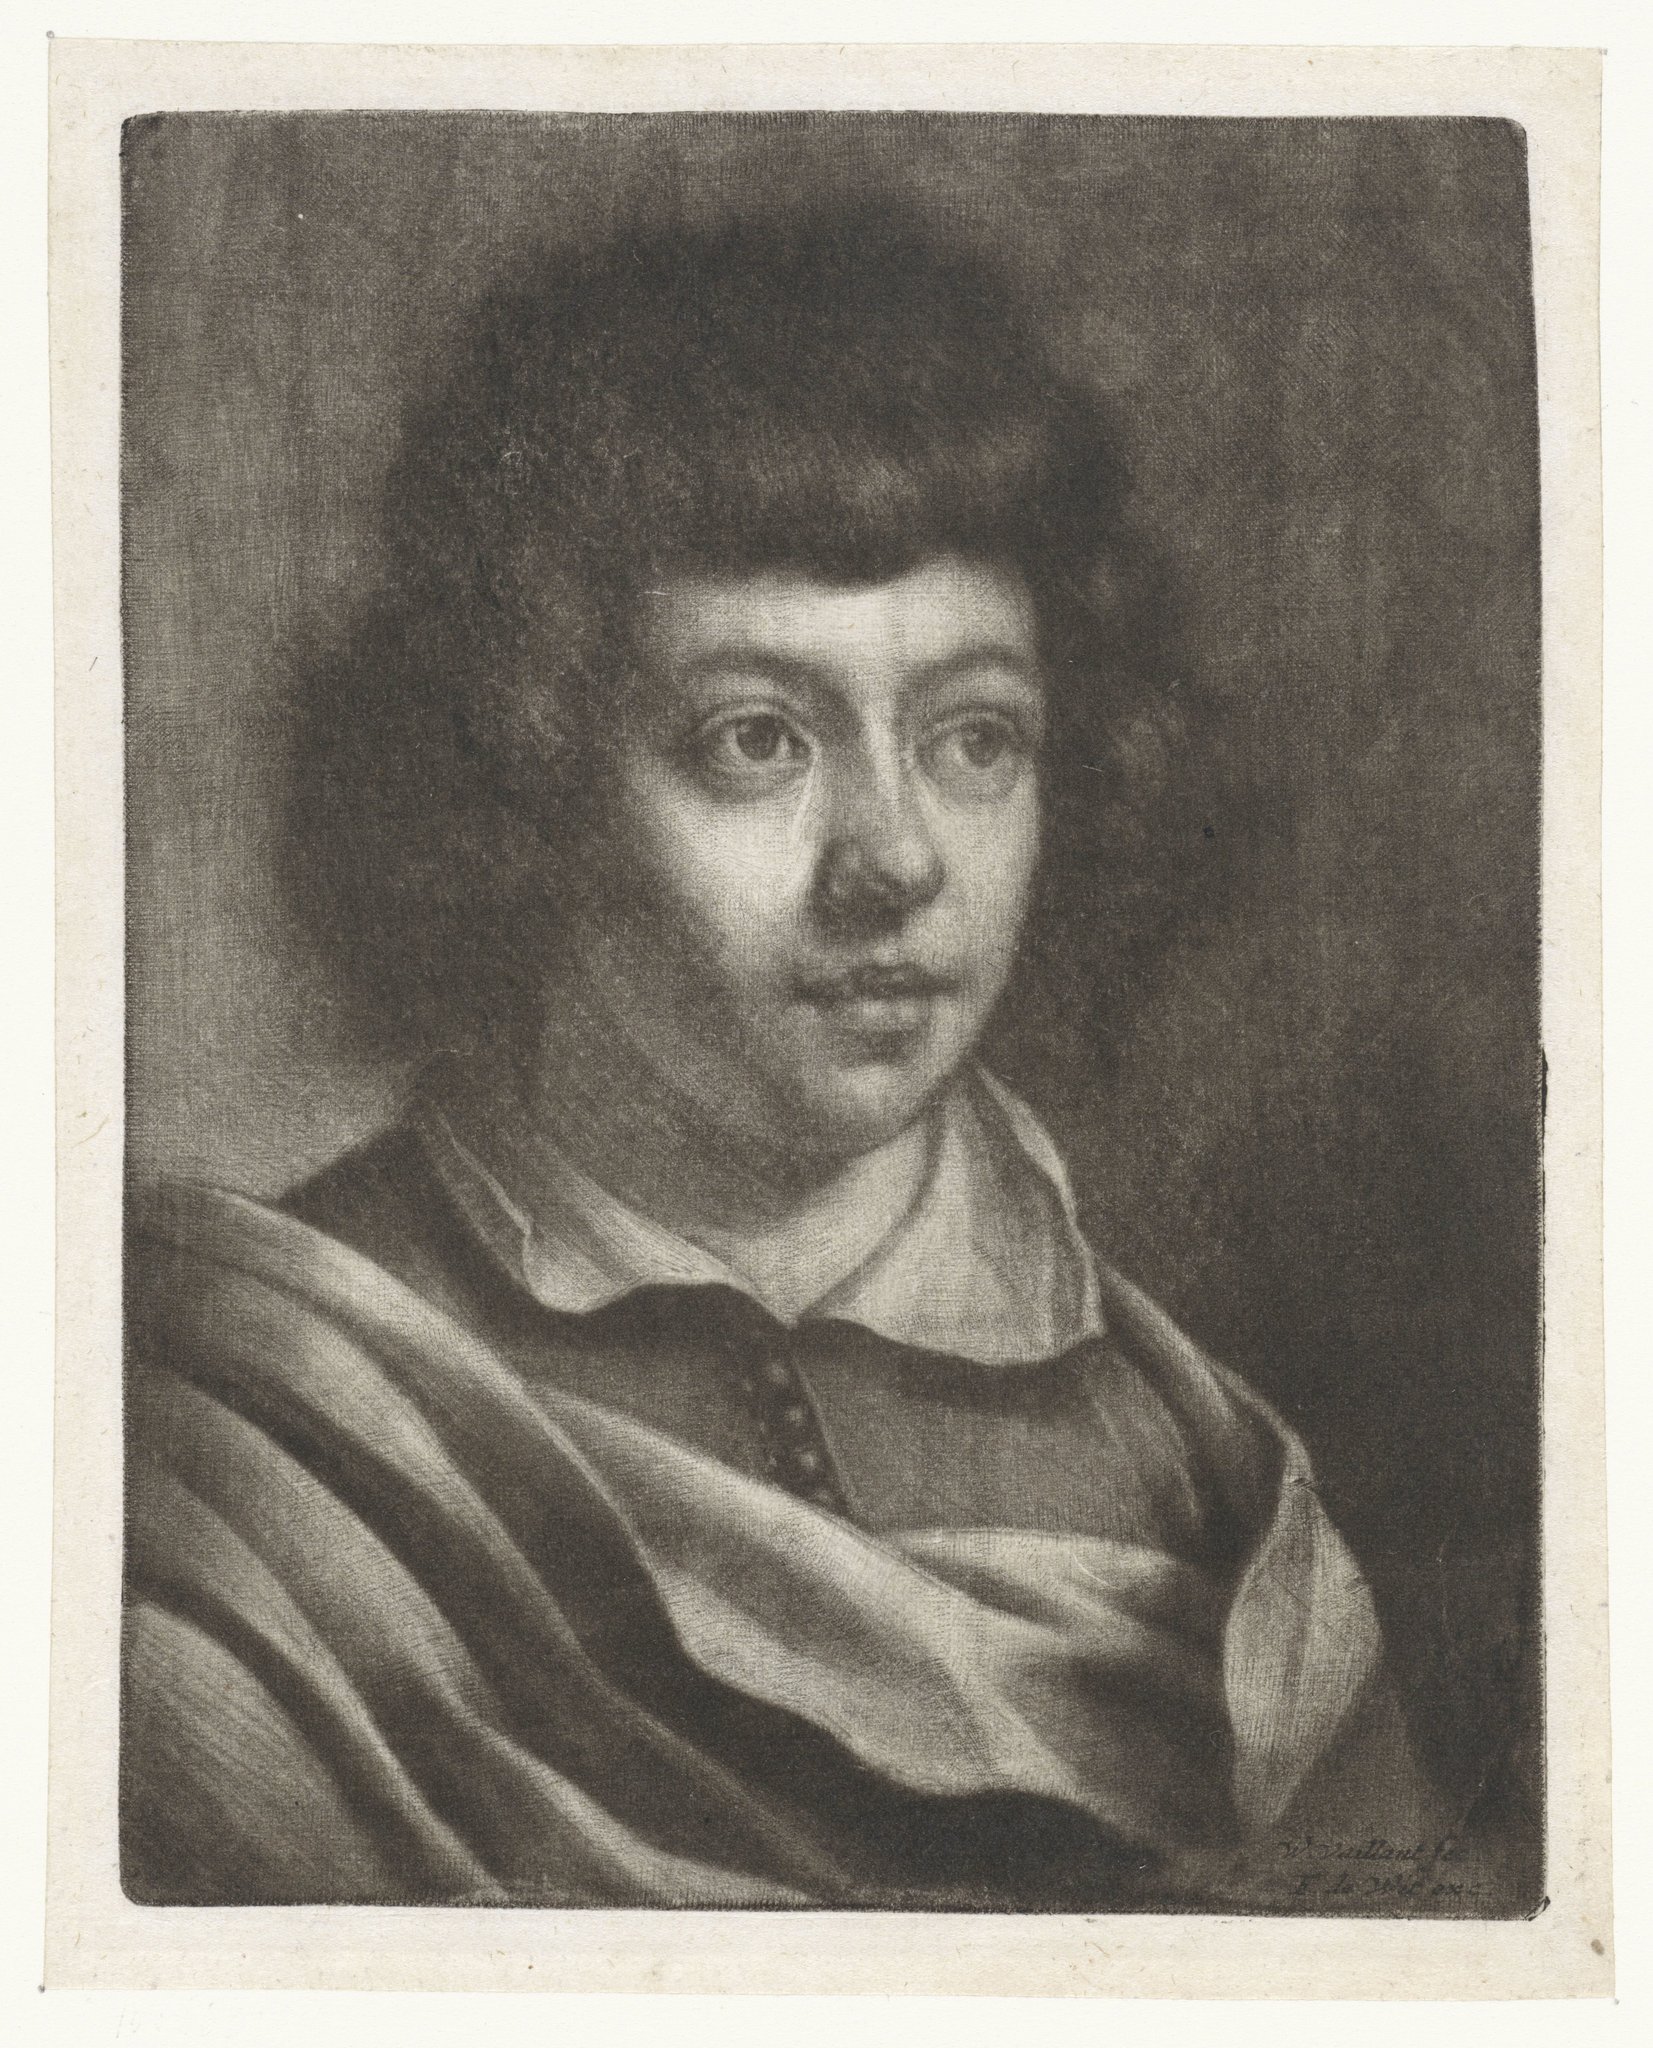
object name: print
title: Jongen met een gevouwen kraag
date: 1658-1706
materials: paper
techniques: mezzotint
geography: amsterdam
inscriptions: collector's mark: Lugt 2228